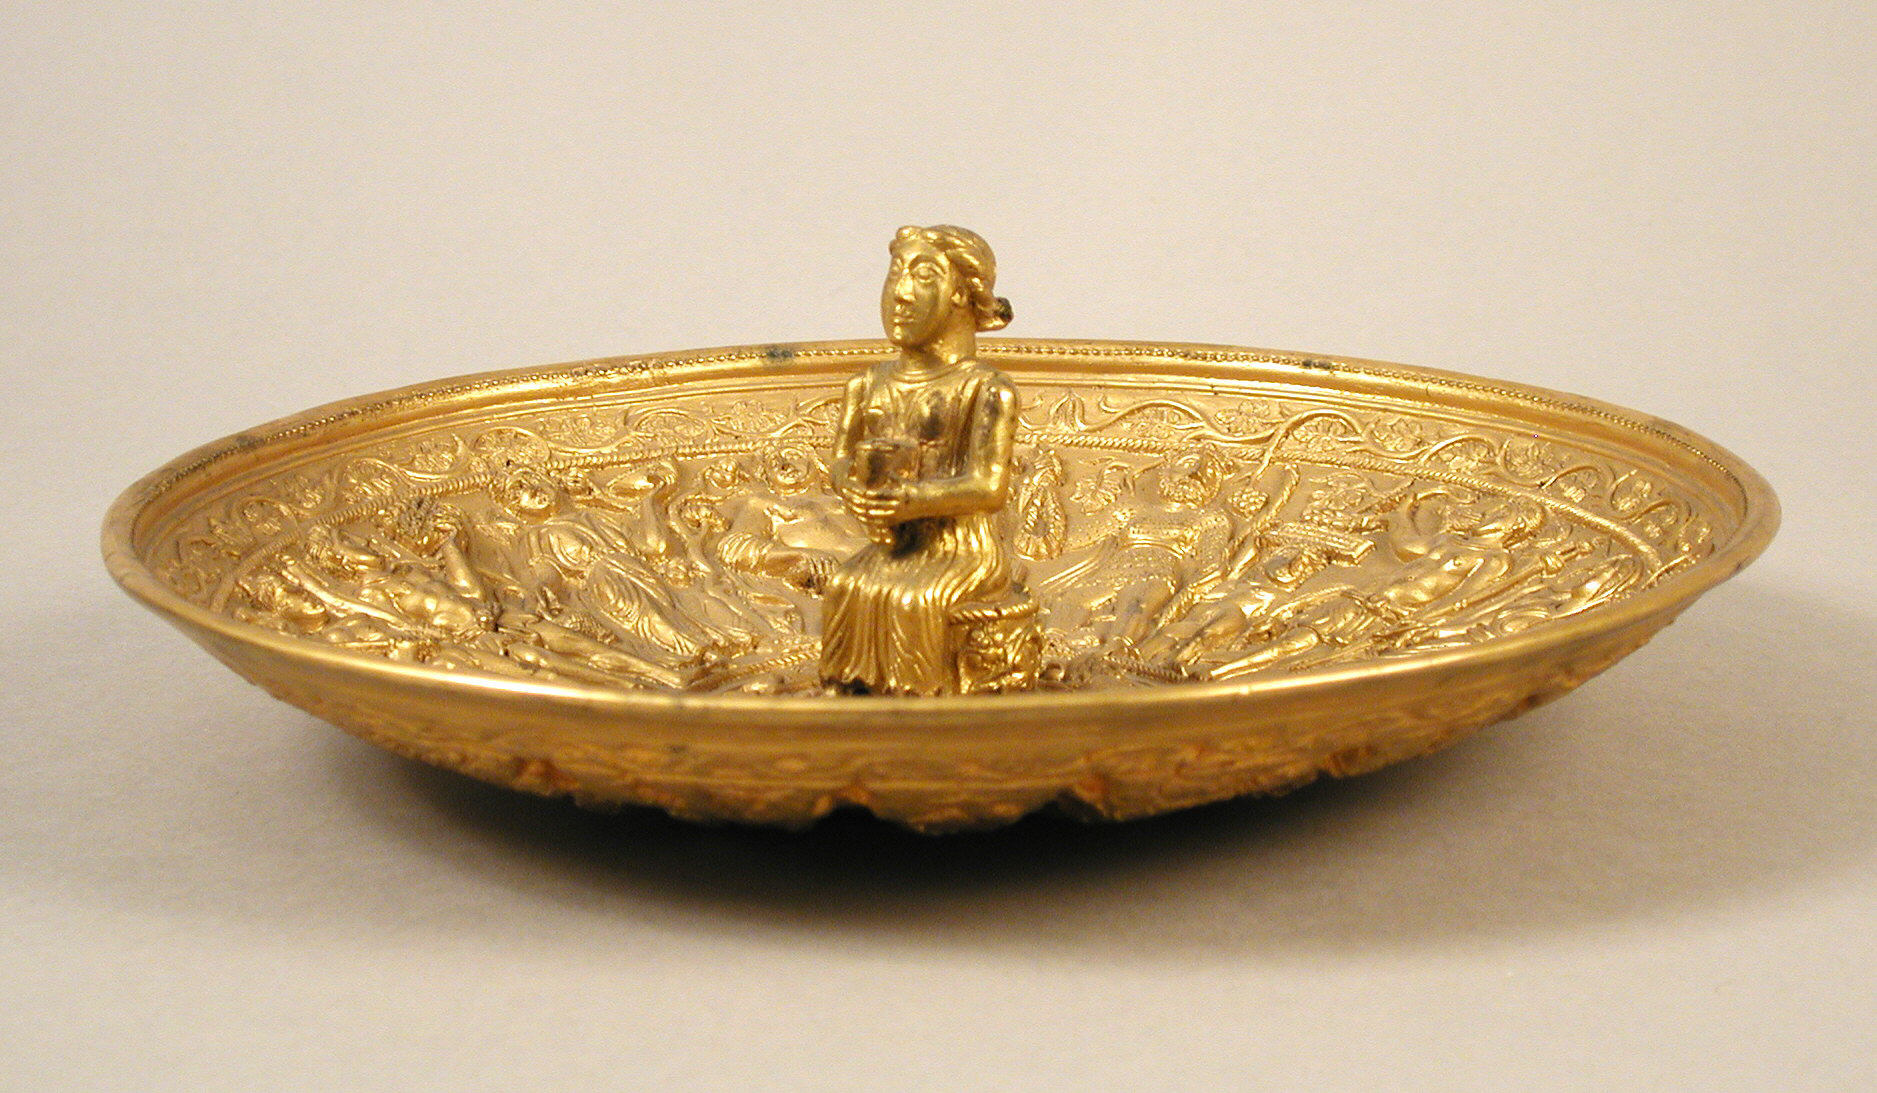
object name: bowl or patera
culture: european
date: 1801-1900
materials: gold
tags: men,women